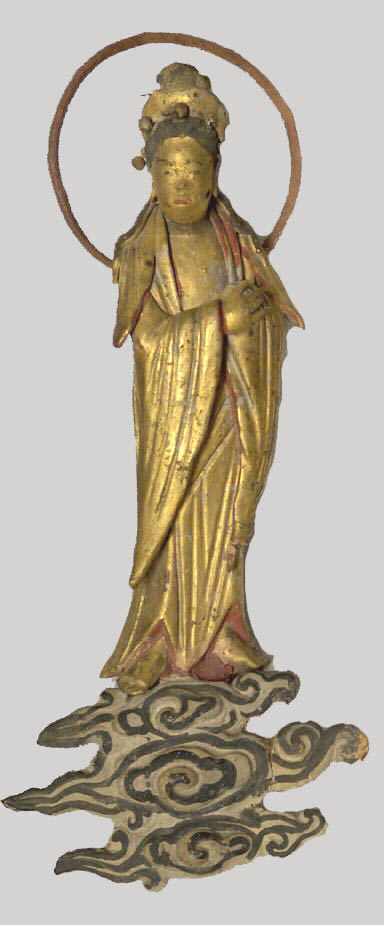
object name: figure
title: Figure of Attendant Deity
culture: chinese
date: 1368-1644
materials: mud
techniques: gilding, painting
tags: deities